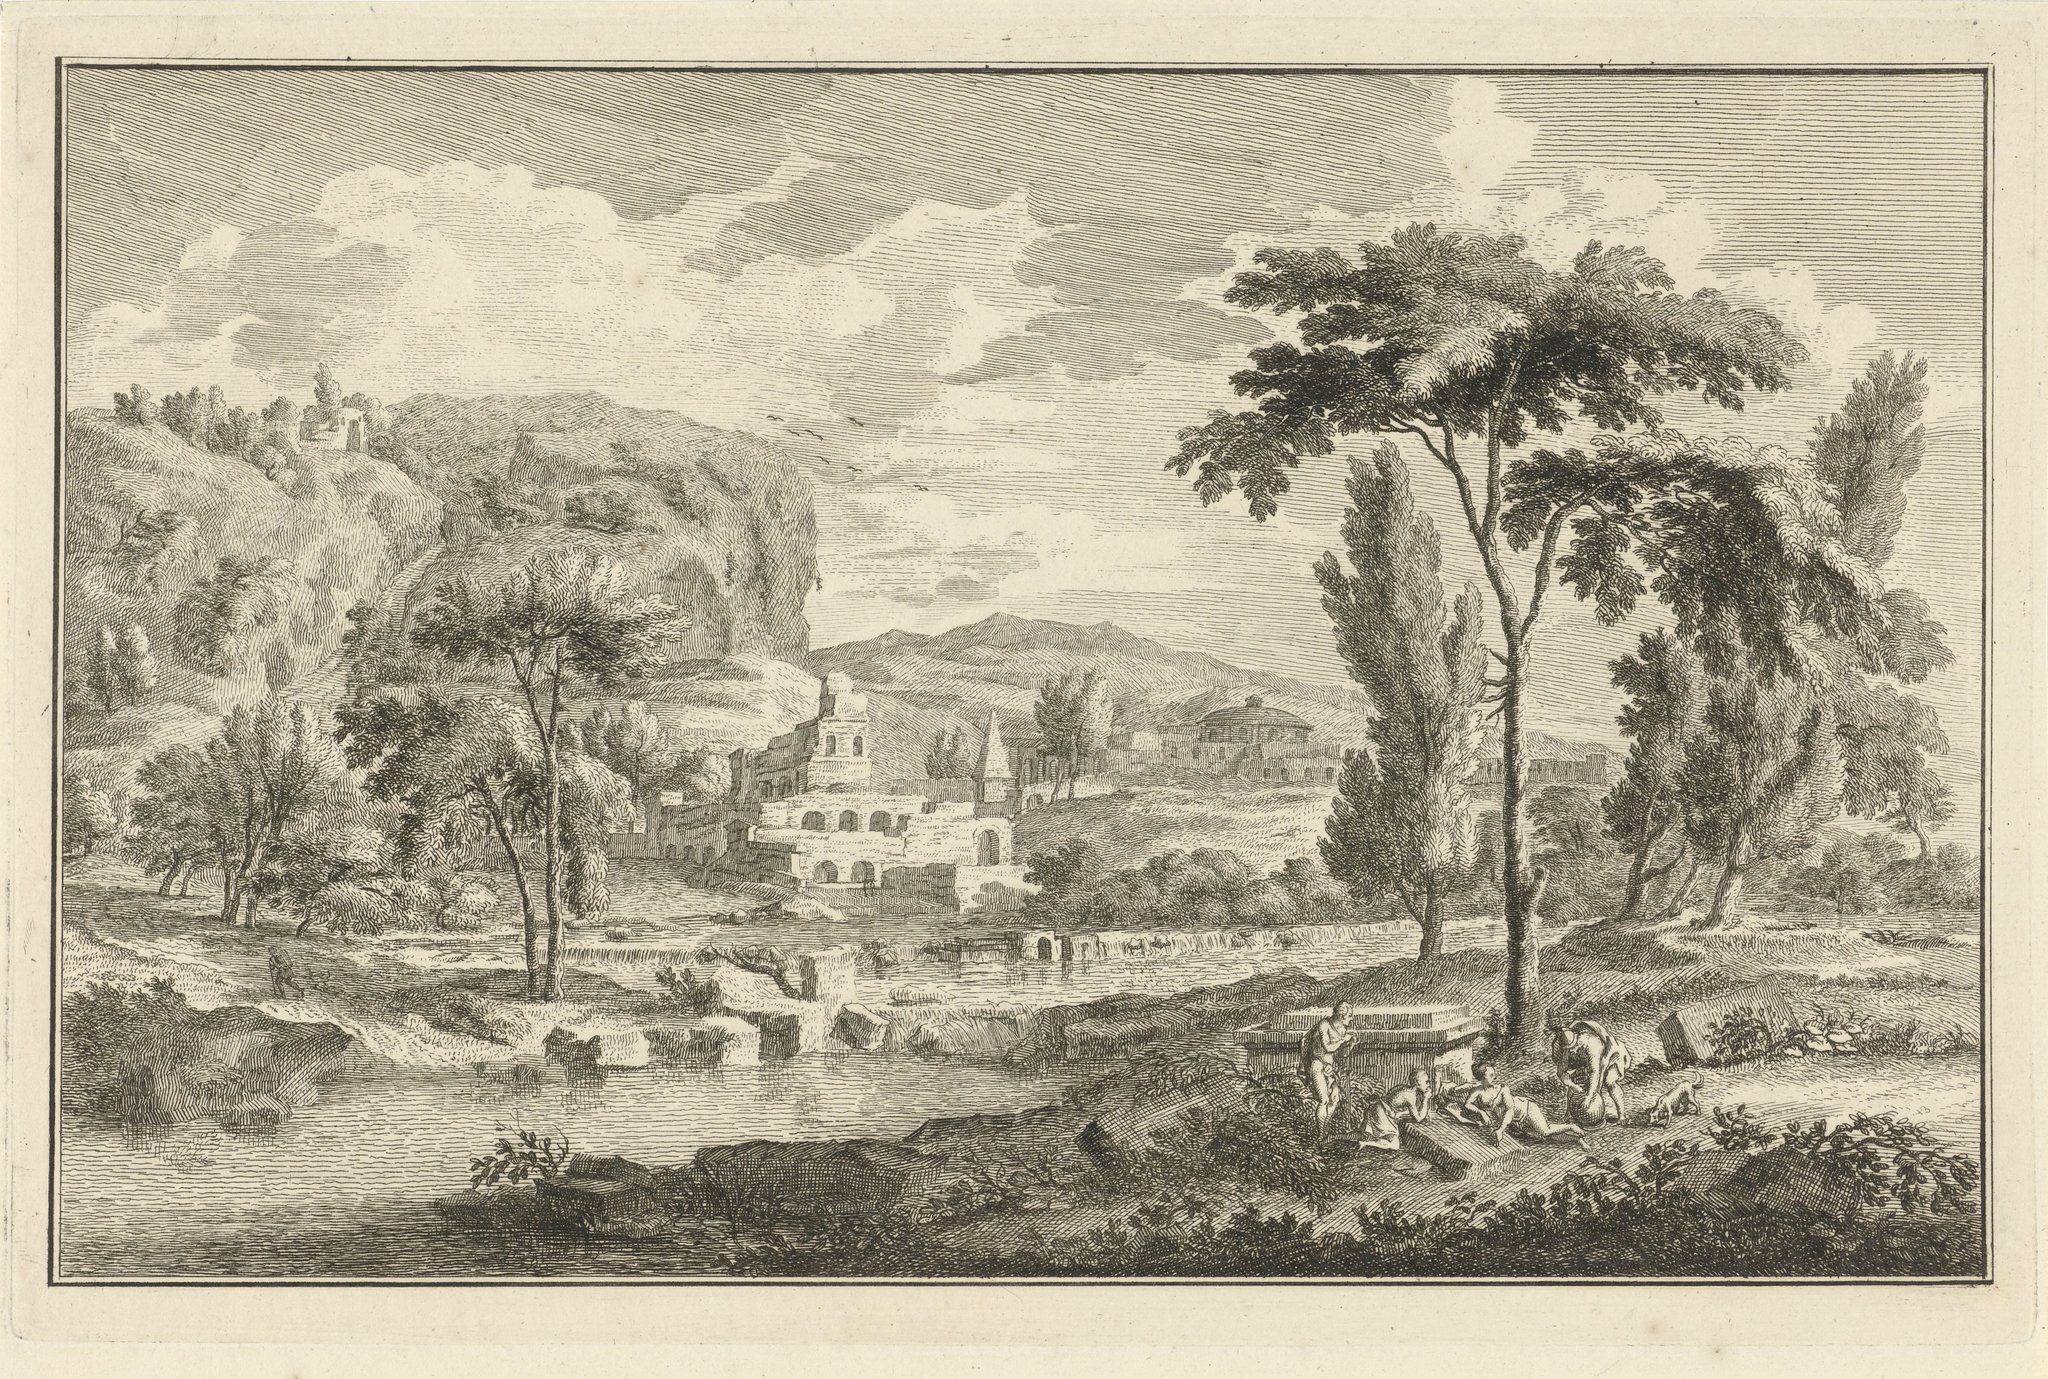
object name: print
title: Italiaanse en Duitse landschappen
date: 1710-1747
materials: paper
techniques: etching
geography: amsterdam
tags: landscapes with waters, waterscapes, seascapes (in the temperate zone), prospect of city, town panorama, silhouette of city, dog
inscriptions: collector's mark: Lugt 240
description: Arcadisch landschap met rivier, rechts vier figuren en een hond op de oever. Aan de andere kant van de rivier ligt een dorp. De prent maakt deel uit van een 40-delige serie prenten met voorstellingen van Italiaanse en Duitse landschappen.